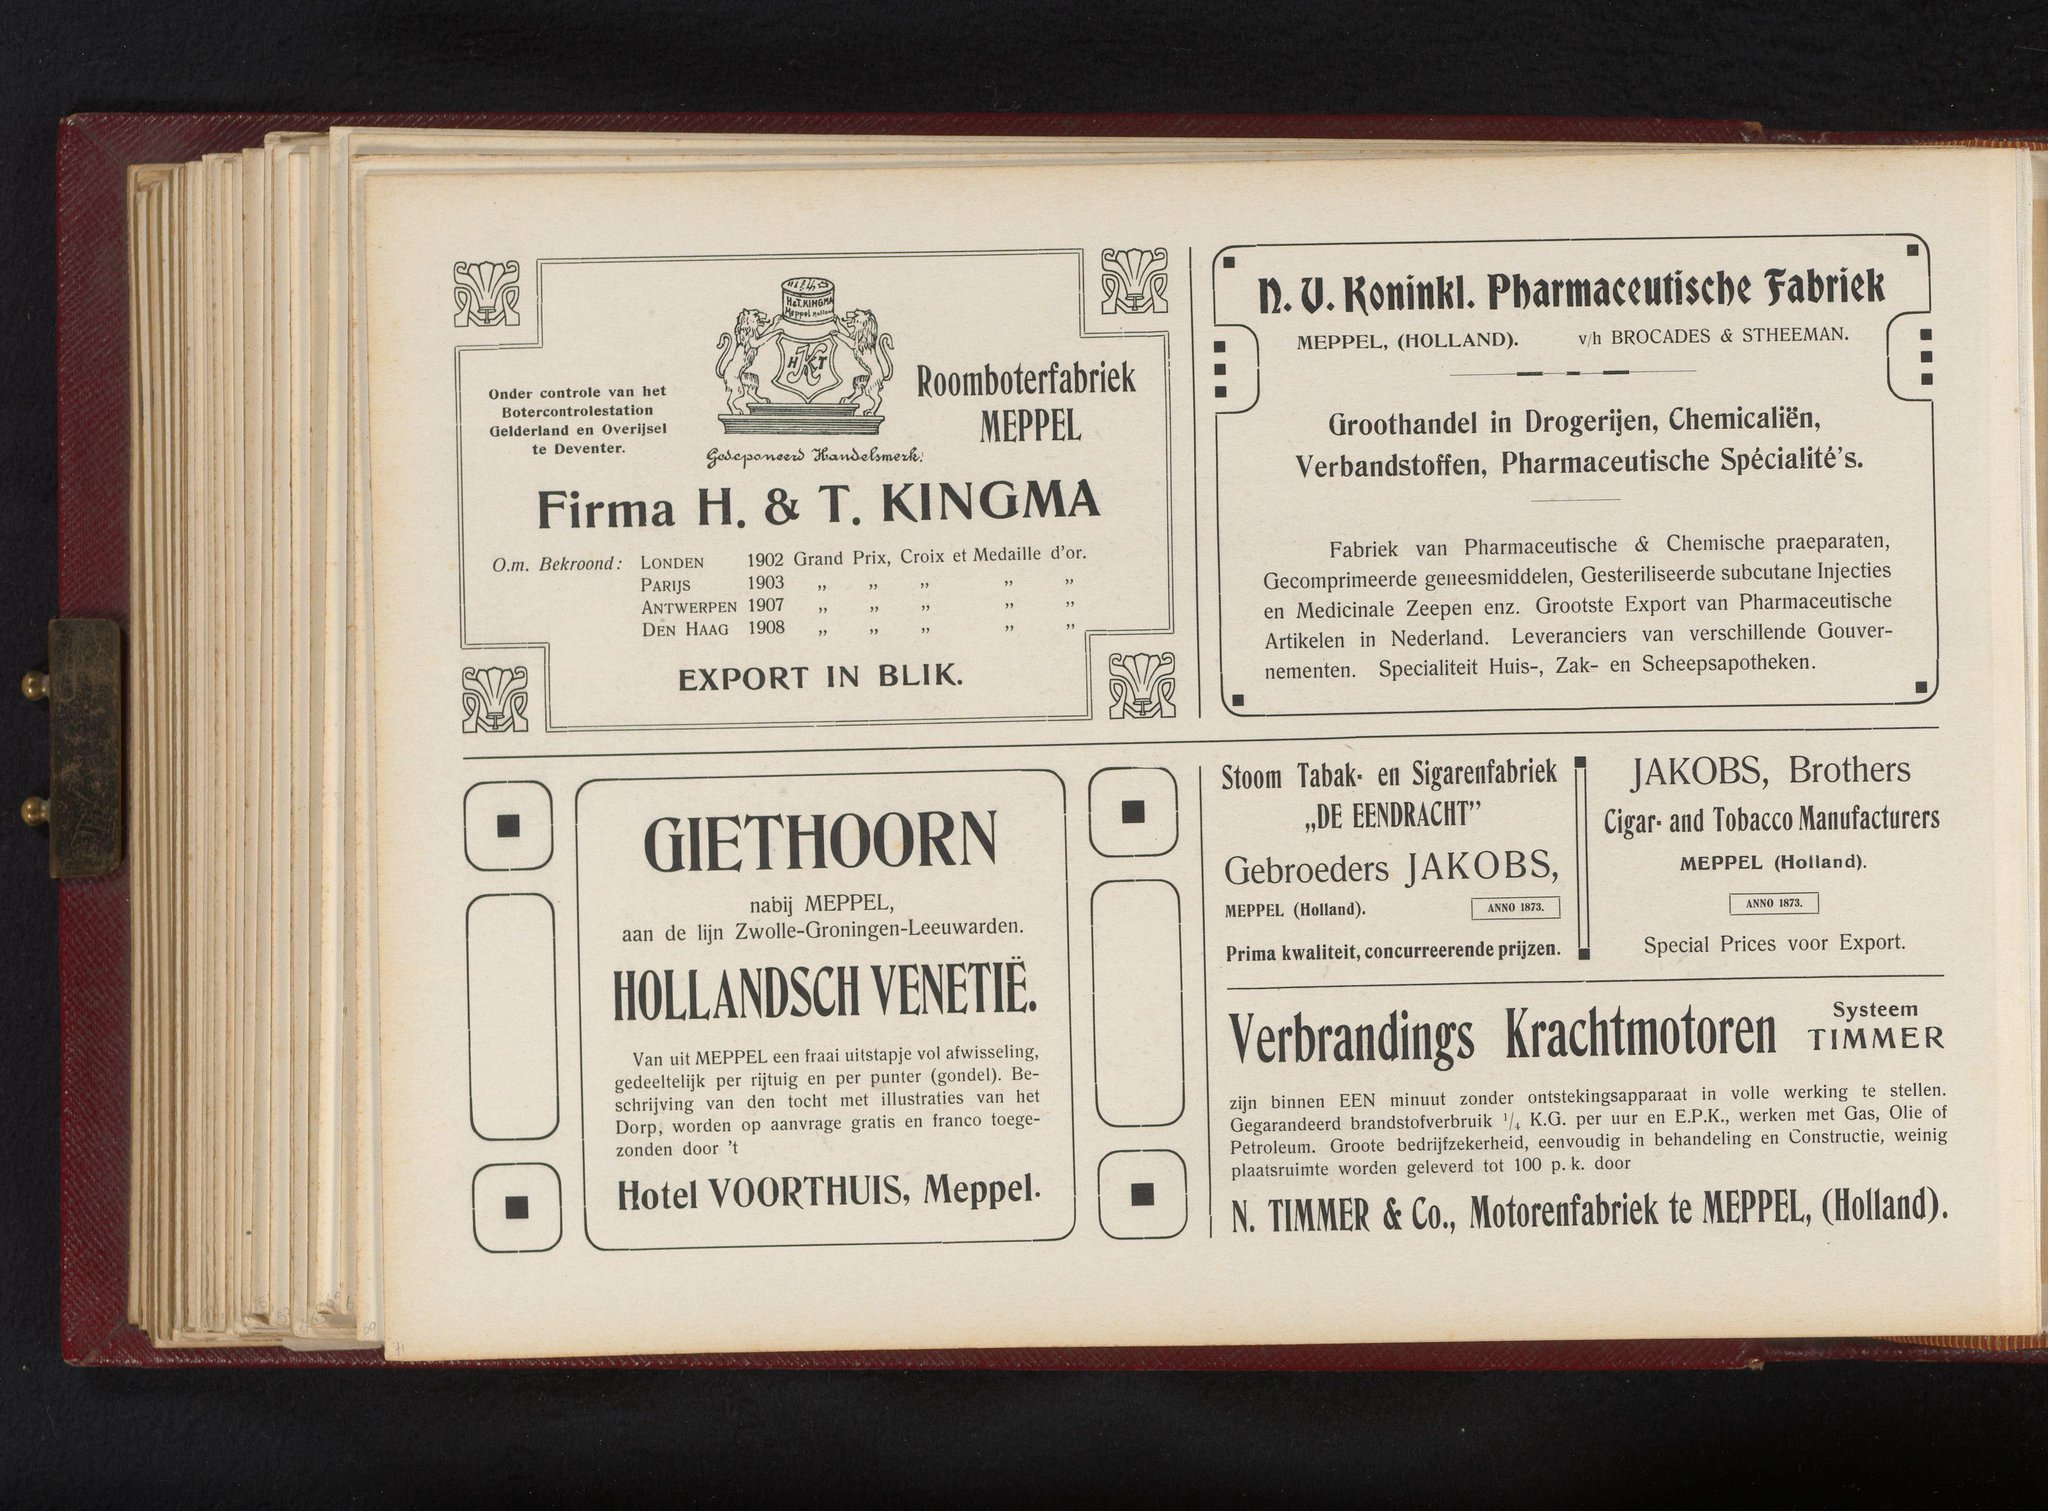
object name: album leaf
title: Advertenties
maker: Anonymous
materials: paper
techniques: printing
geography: netherlands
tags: advertising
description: Advertenties voor onder andere Roomboterfabriek Meppel Firma H. & T. Kingma, N.V. Koninkl. Pharmaceutische Fabriek v/h. Brocades & Steenman, Hotel Voorthuis, Stoom Tabak- en Sigarenfabriek De Eendracht Gebr. Jakobs en N. Timmer & Co. Motorenfabriek. Deze pagina maakt deel uit van een album.